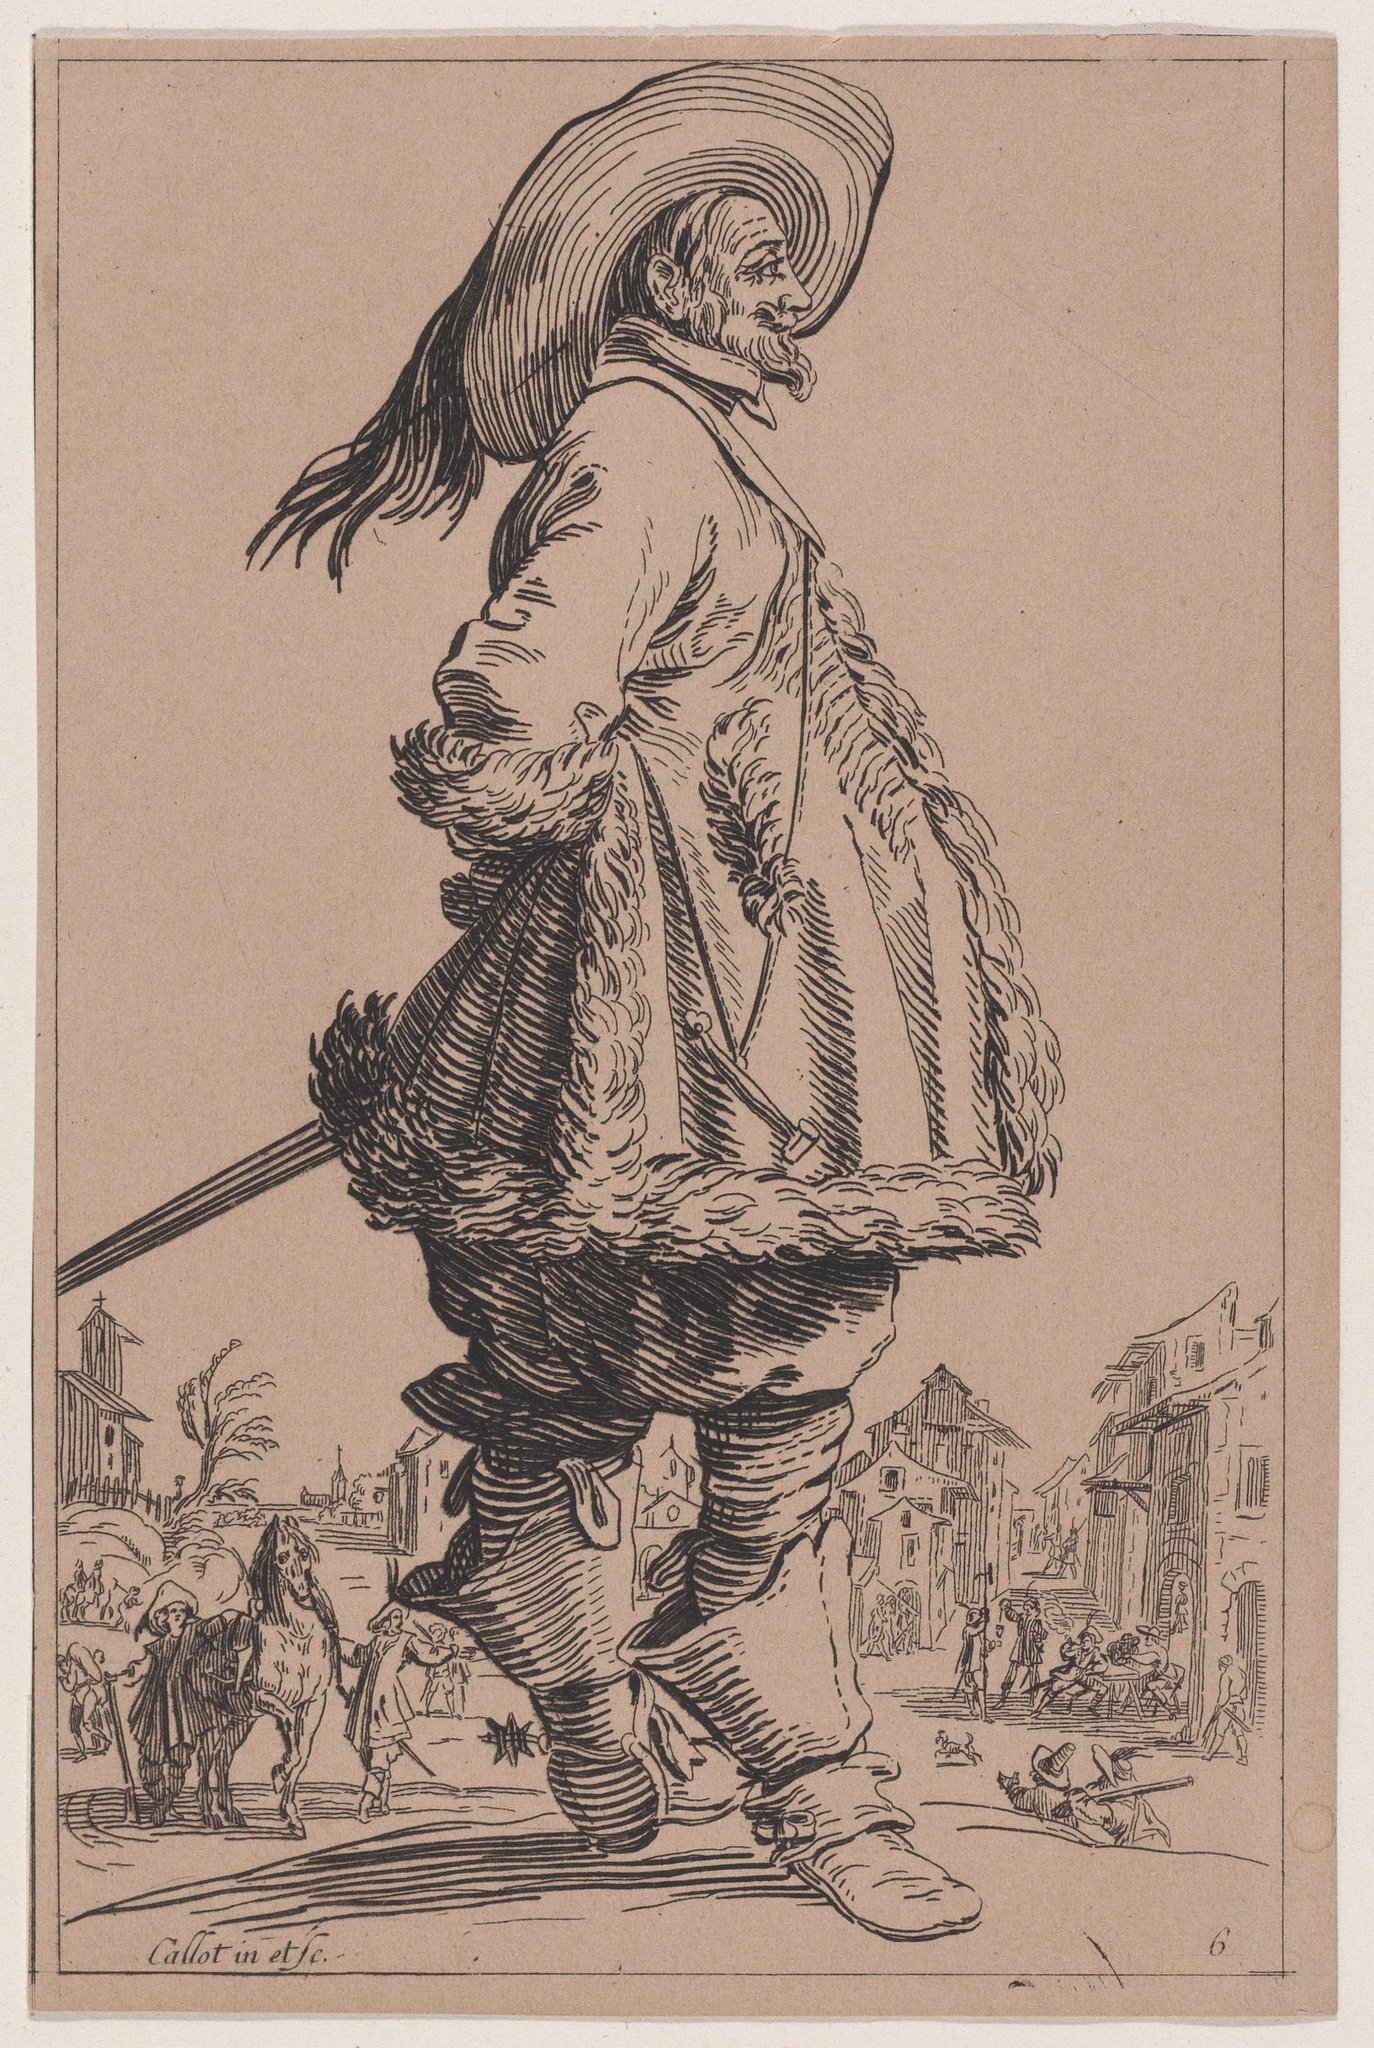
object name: print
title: Copy of Le Gentilhomme au Manetau Bordé de Fourrures Tenant ses Mains Derrière le Dos (The Gentleman with a Fur-Lined Mantle Holding his Hands Behind his Back), from La Noblesse (The Nobility)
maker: Anonymous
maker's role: artist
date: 1601-1700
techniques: etching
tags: men